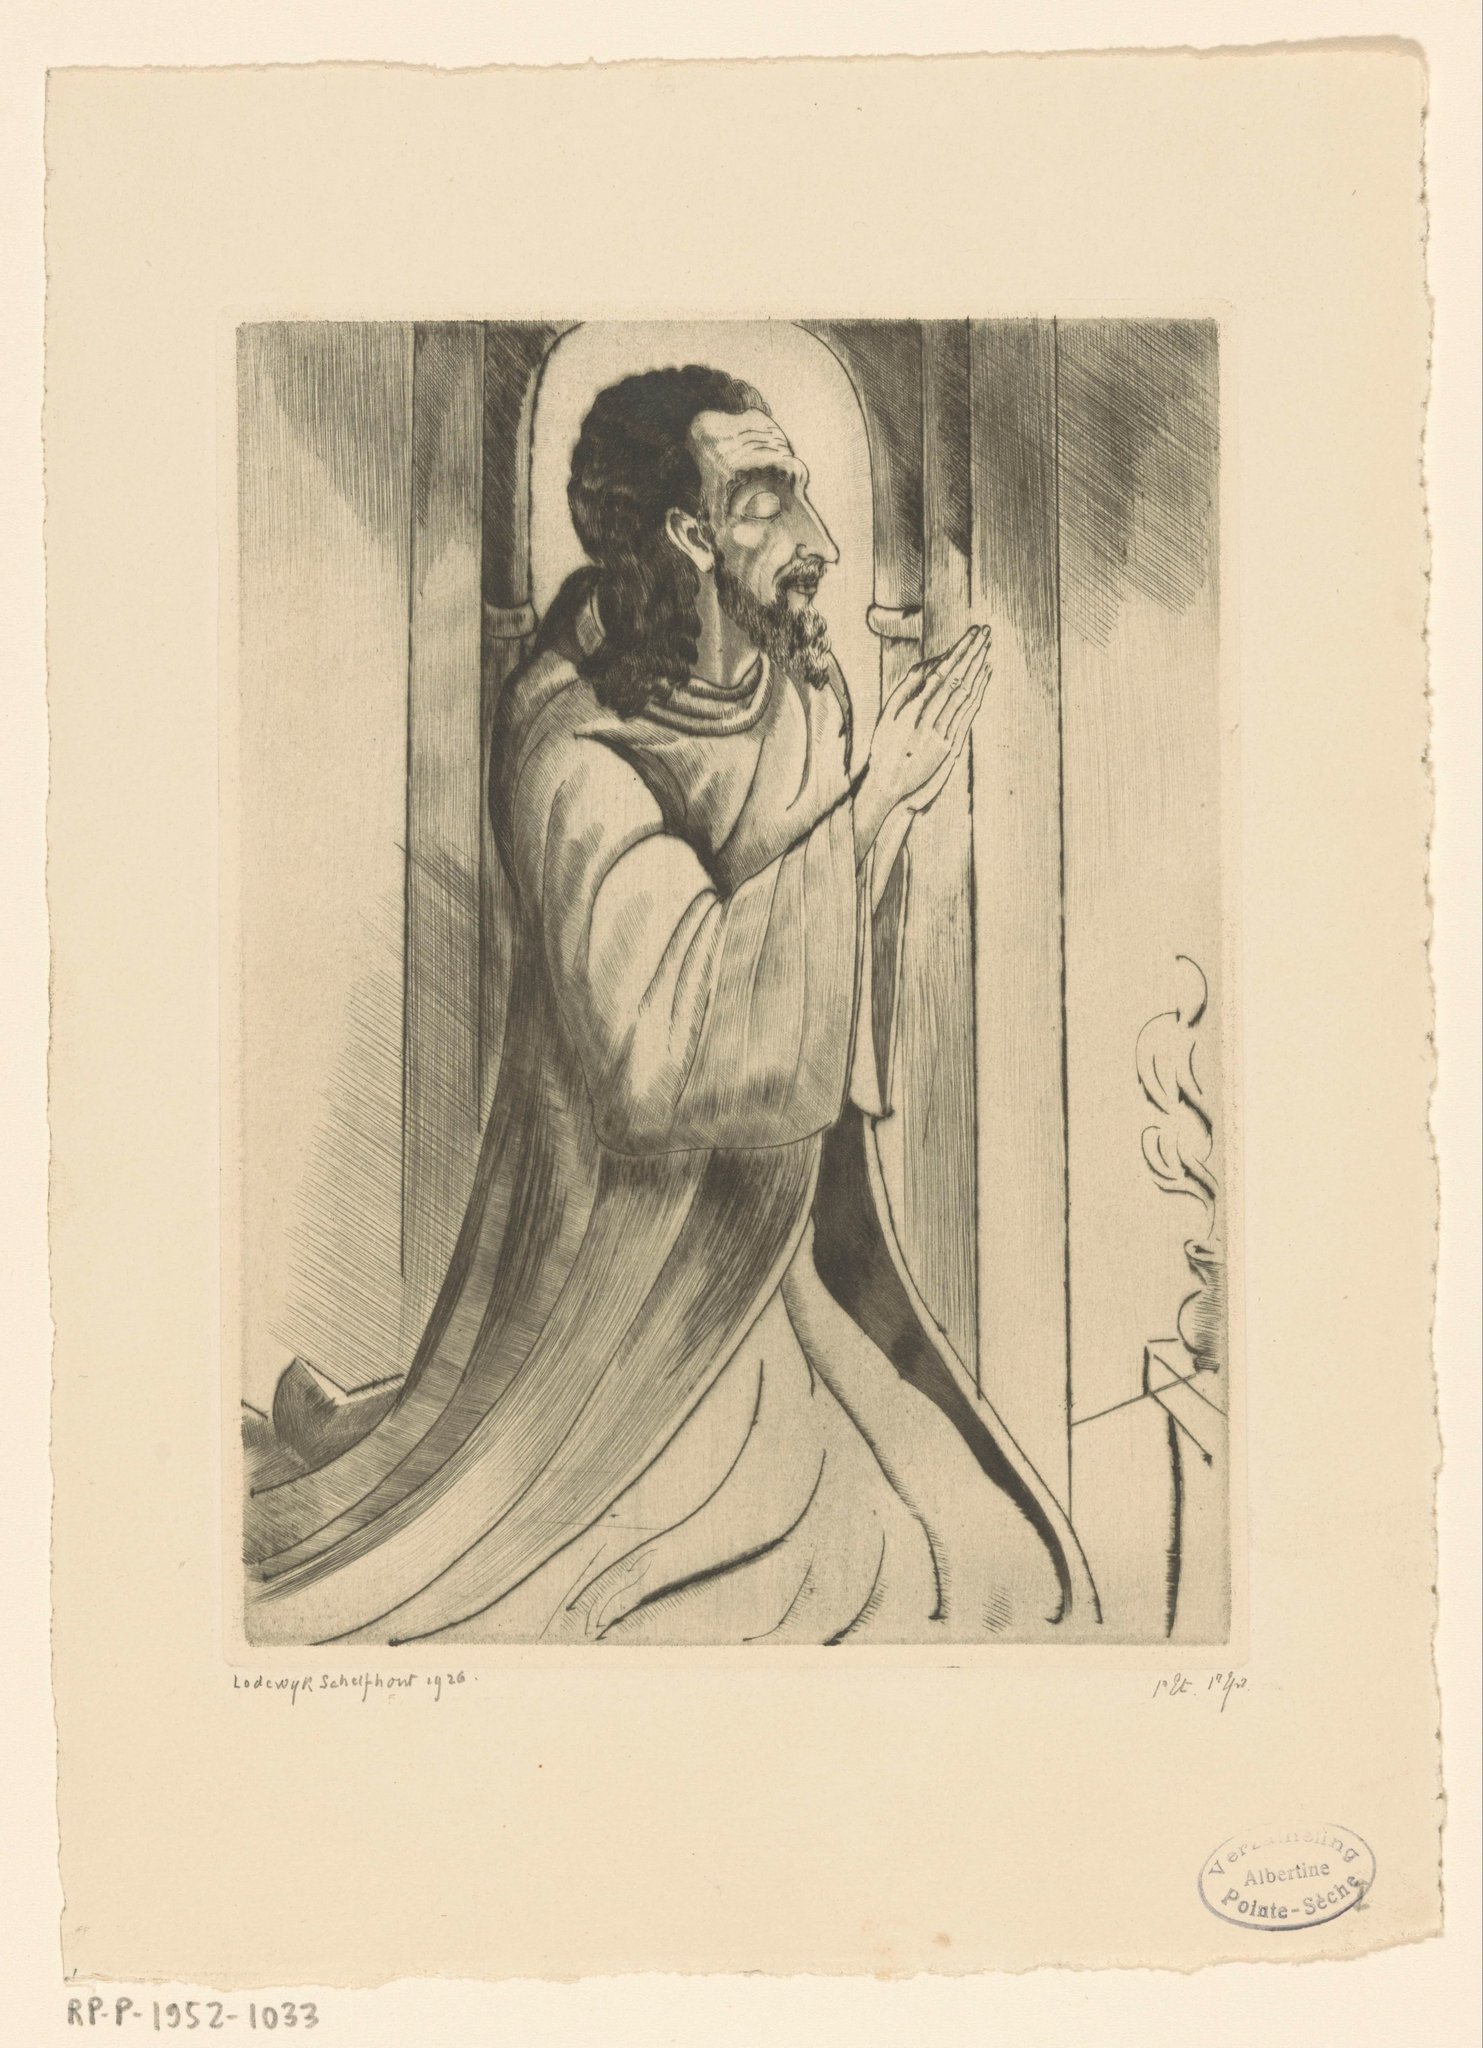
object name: print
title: La Prière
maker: lodewijk schelfhout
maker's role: draughtsman, print maker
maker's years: 1881-1943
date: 1926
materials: paper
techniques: drypoint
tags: (public) prayer, incense-burner ~ scents, perfumes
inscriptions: collector's mark: Lugt 5i, collector's mark: Lugt 2228, collector's mark: Lugt 2760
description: Een knielende, bebaarde man met samengevouwen handen. Rechts een wierookvat waaruit rook opstijgt.